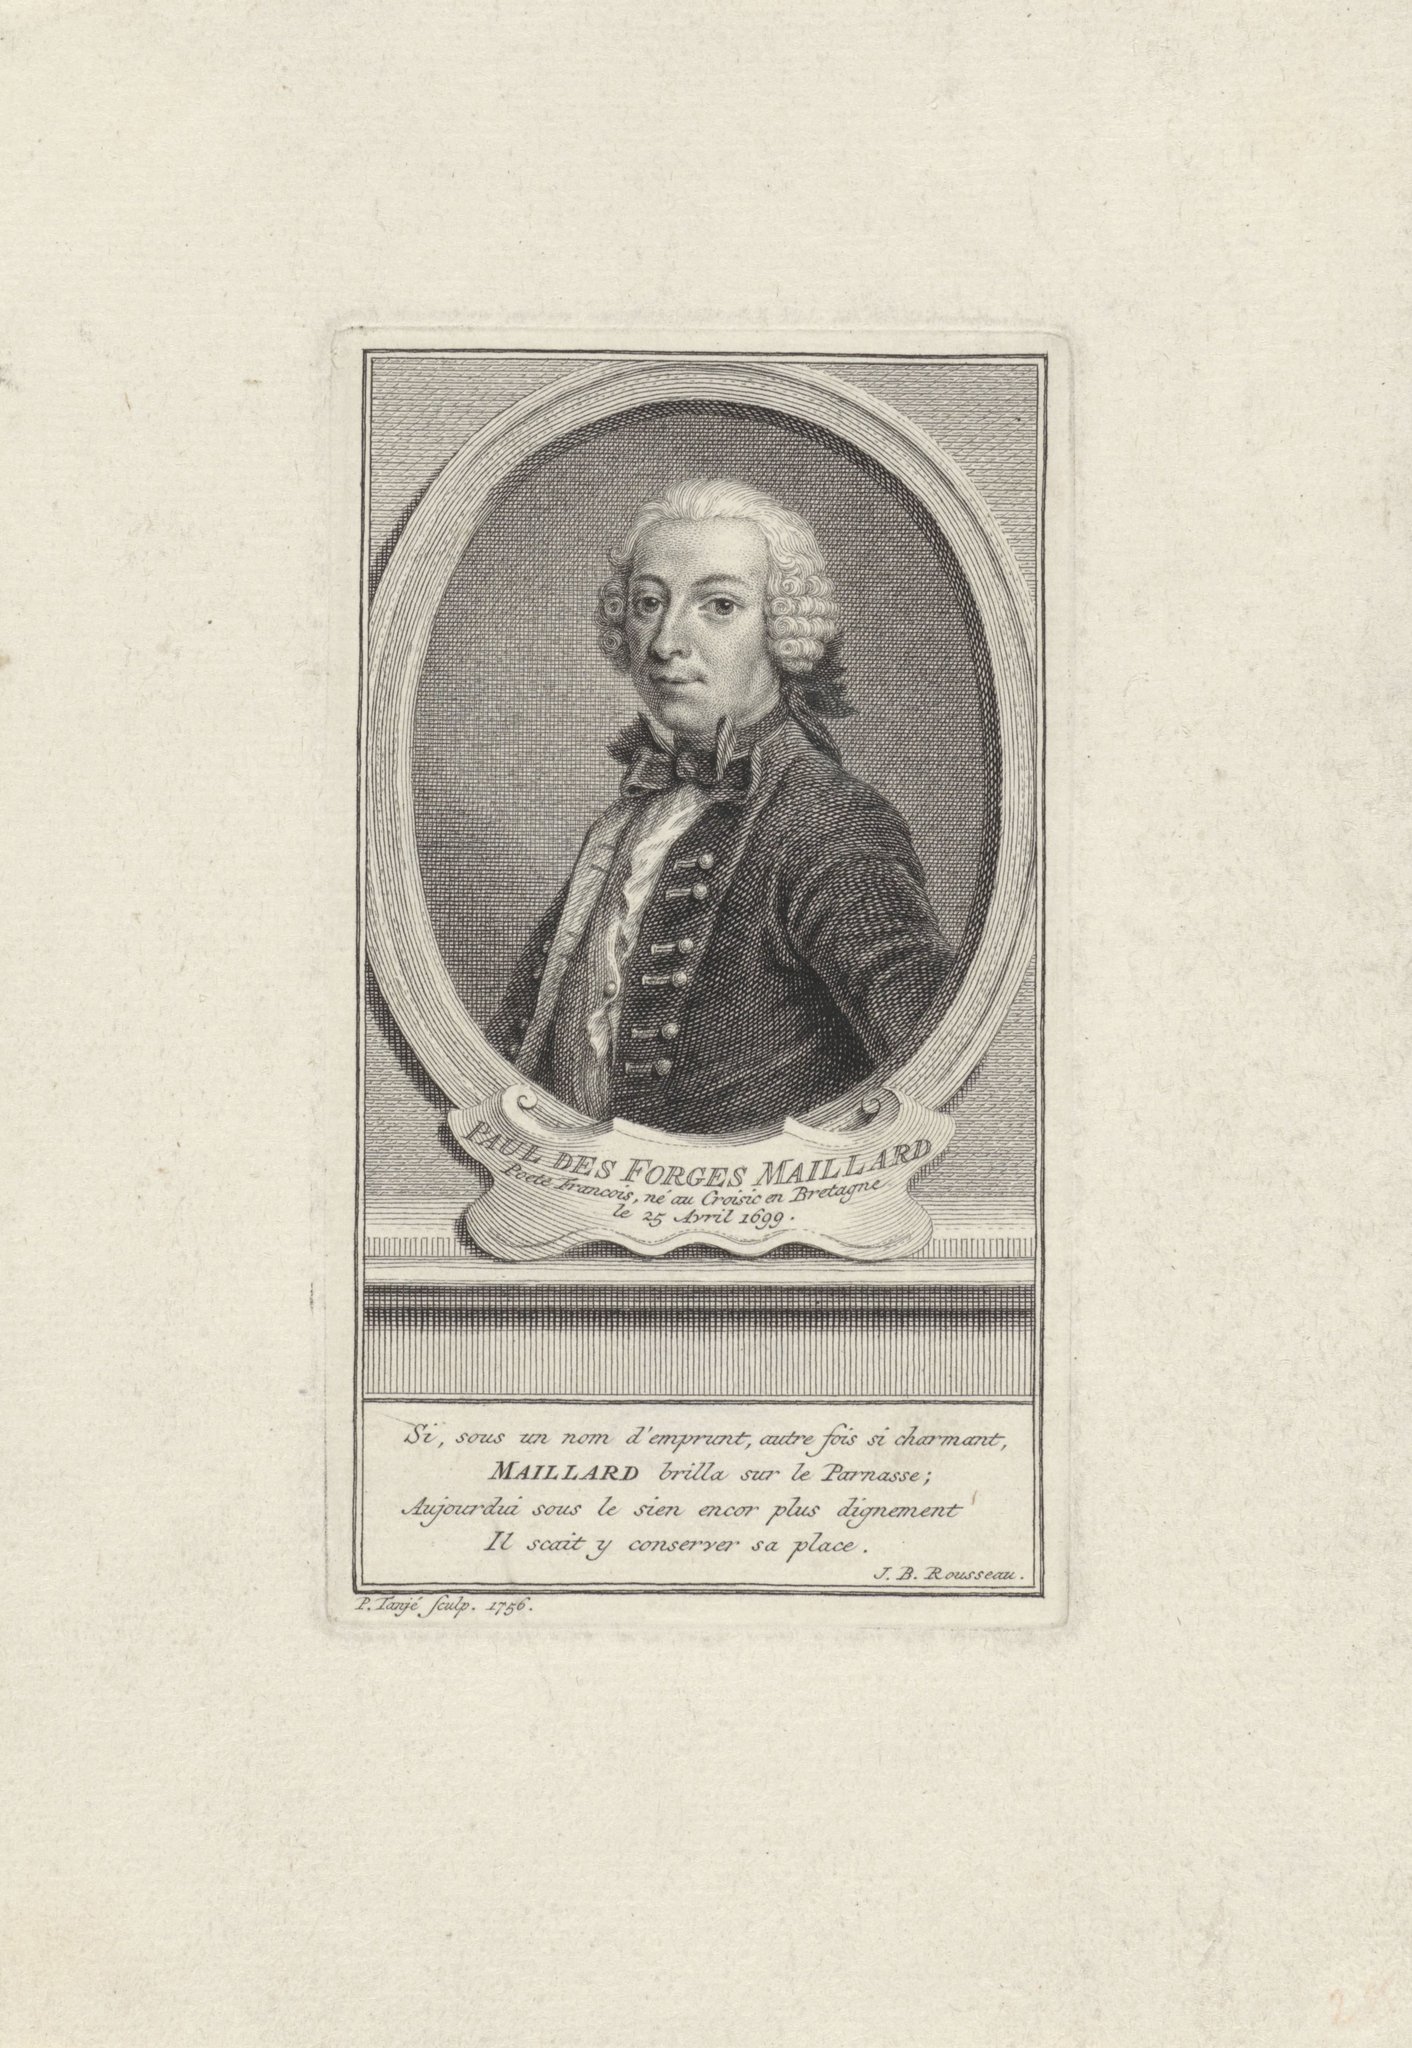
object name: print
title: Portret van Paul Desforges-Maillard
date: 1756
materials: paper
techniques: engraving, etching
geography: amsterdam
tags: dichter, paul desforges-maillard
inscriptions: collector's mark: Lugt 1337, collector's mark: Lugt 2228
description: Portret van Paul Desforges-Maillard, Frans dichter. Onderaan in de marge een vierregelig vers in het Frans.